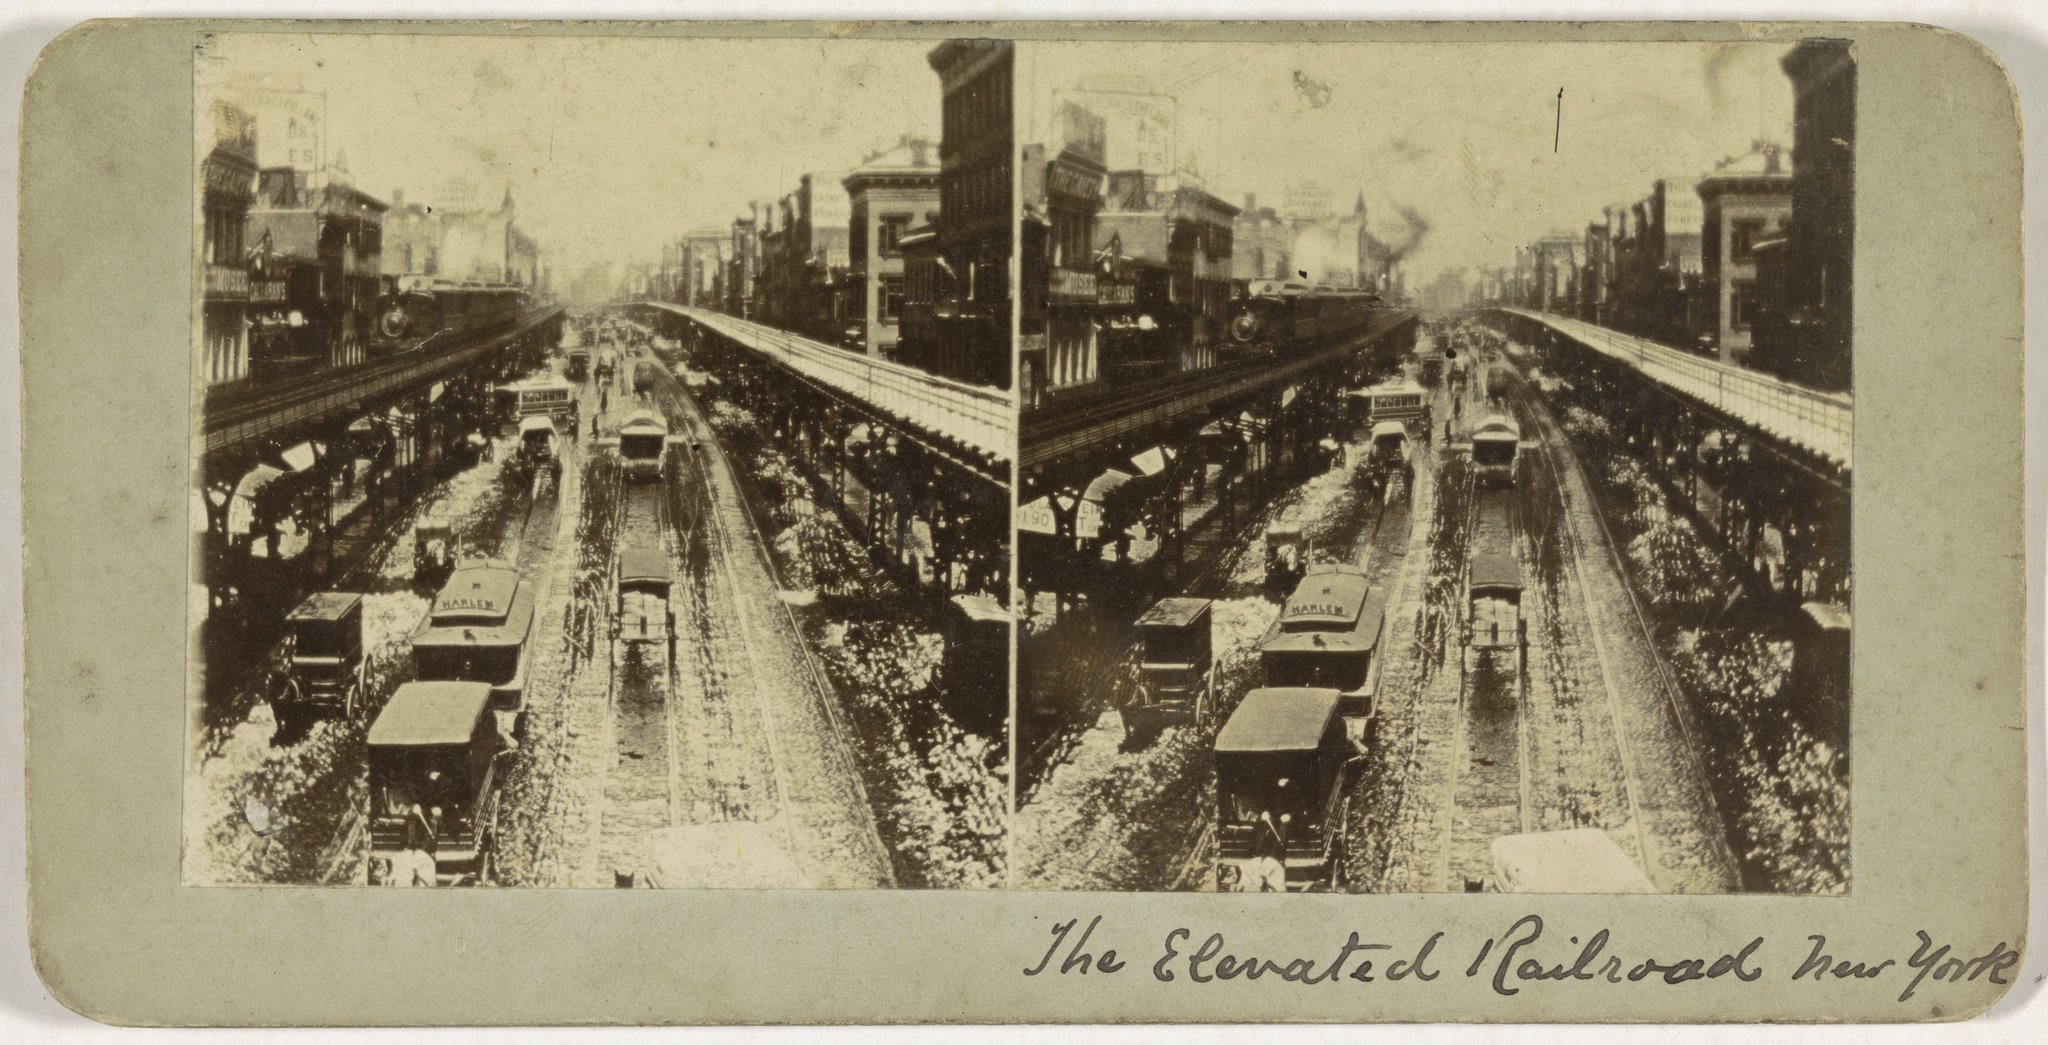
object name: stereograph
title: Gezicht op de 'Elevated', de verhoogde spoorlijn in New York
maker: Anonymous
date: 1850-1880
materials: cardboard, paper, photographic support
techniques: albumen print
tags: new york (city)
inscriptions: inscription: ‘€7,-’, title: ‘The Elevated Railroad New York’